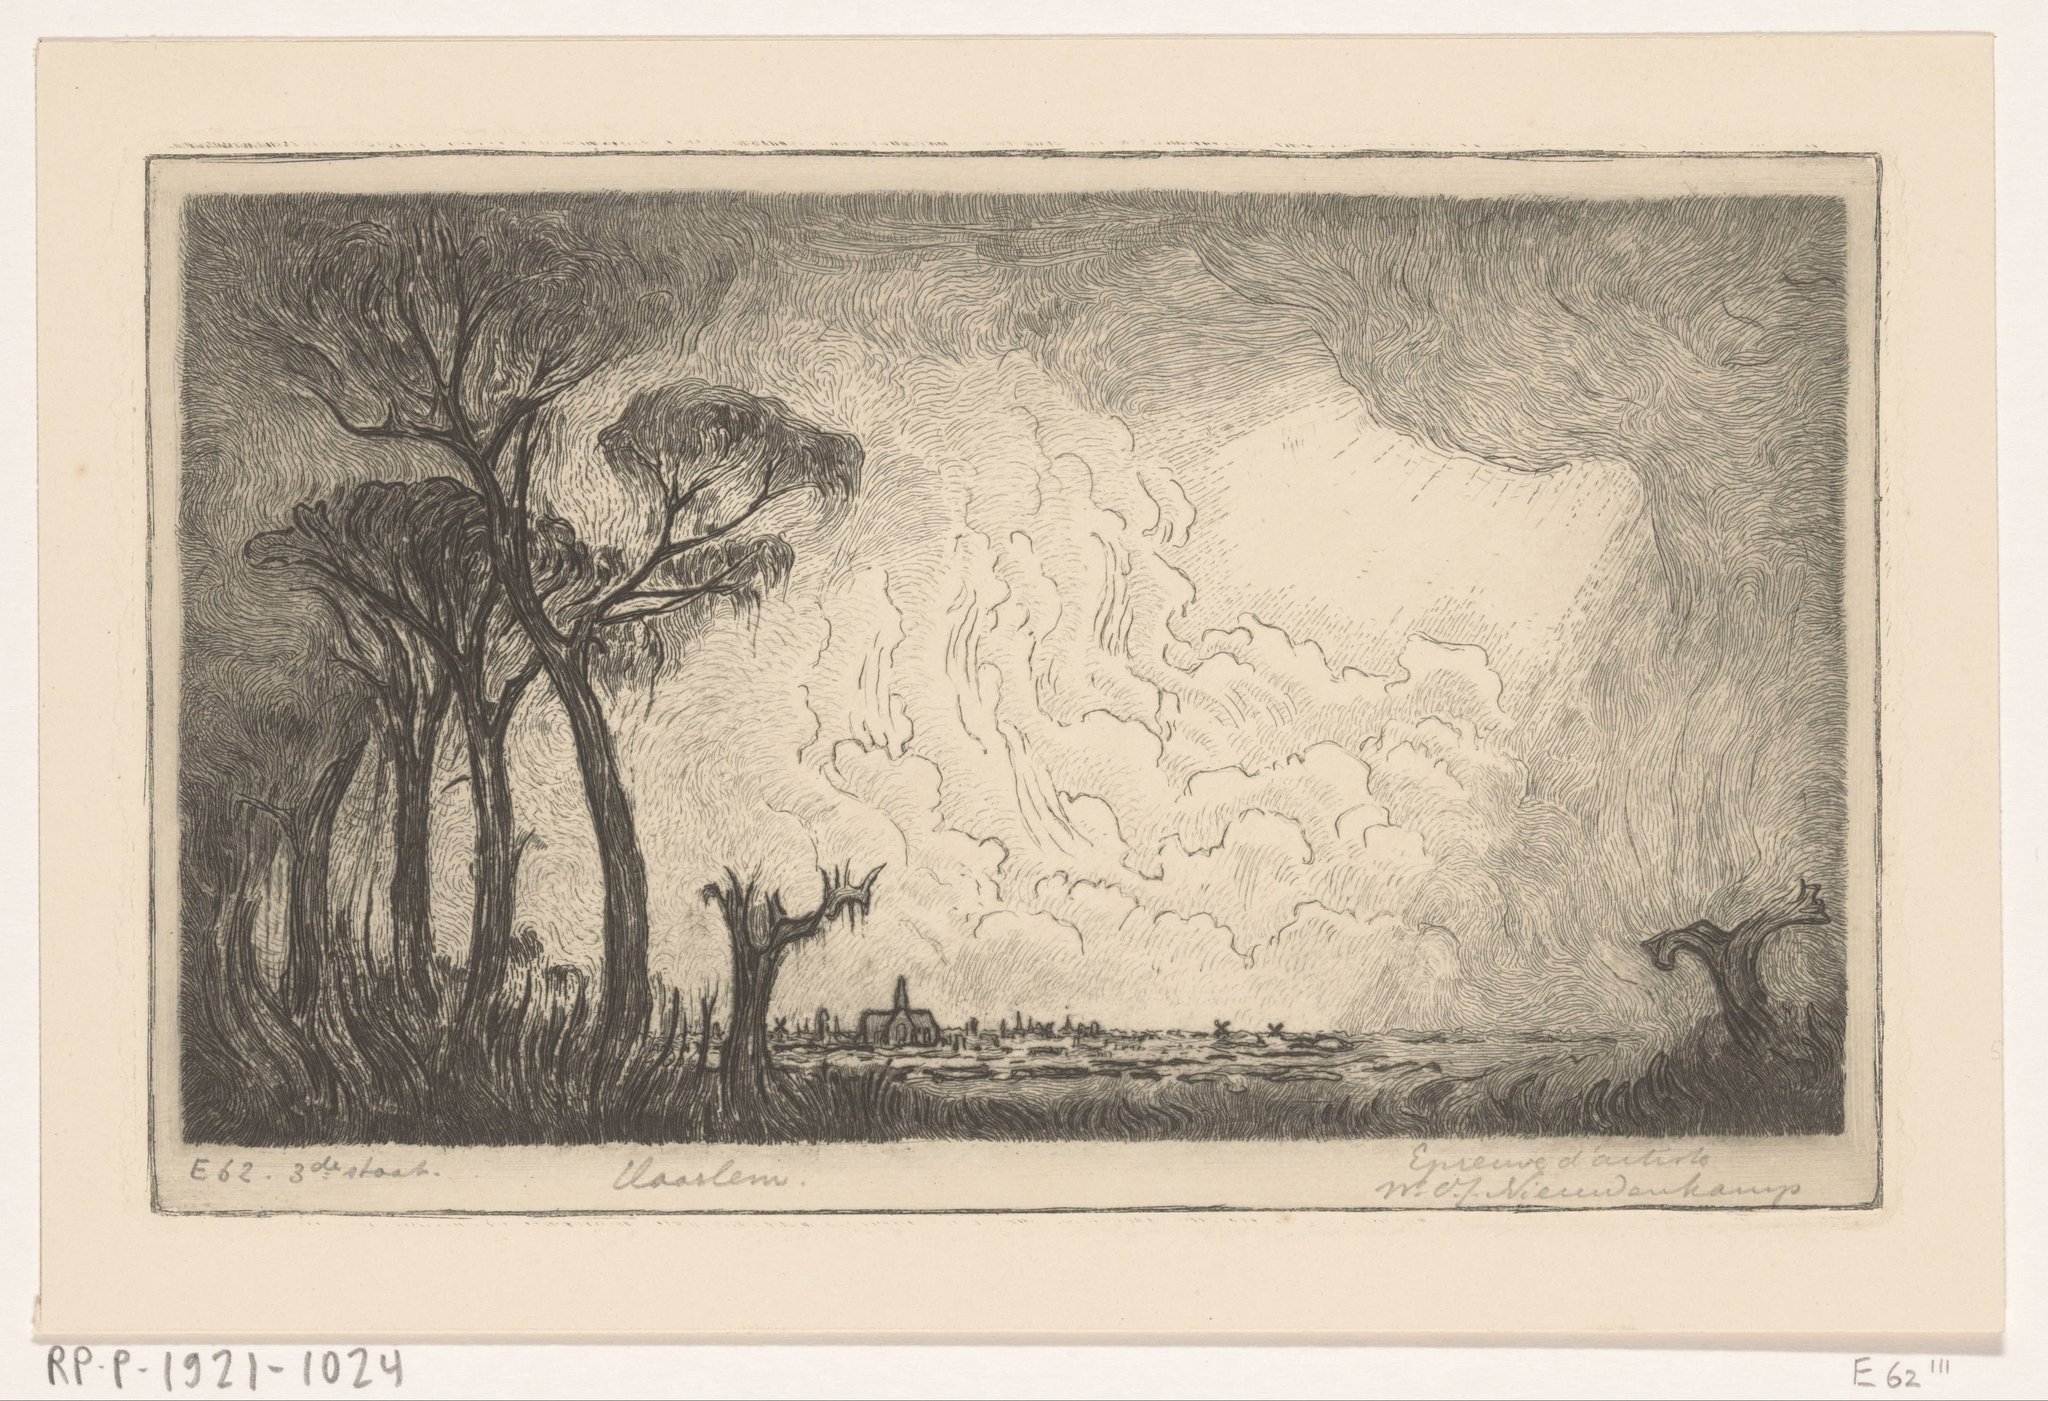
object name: print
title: Gezicht op Haarlem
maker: wijnand otto jan nieuwenkamp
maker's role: draughtsman, print maker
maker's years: 1874-1950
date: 1902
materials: paper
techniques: etching, intaglio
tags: trees, prospect of city, town panorama, silhouette of city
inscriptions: collector's mark: Lugt 2233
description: Op de voorgrond bomen. Op de achtergrond het silhouet van de Grote of Sint-Bavokerk in Haarlem.